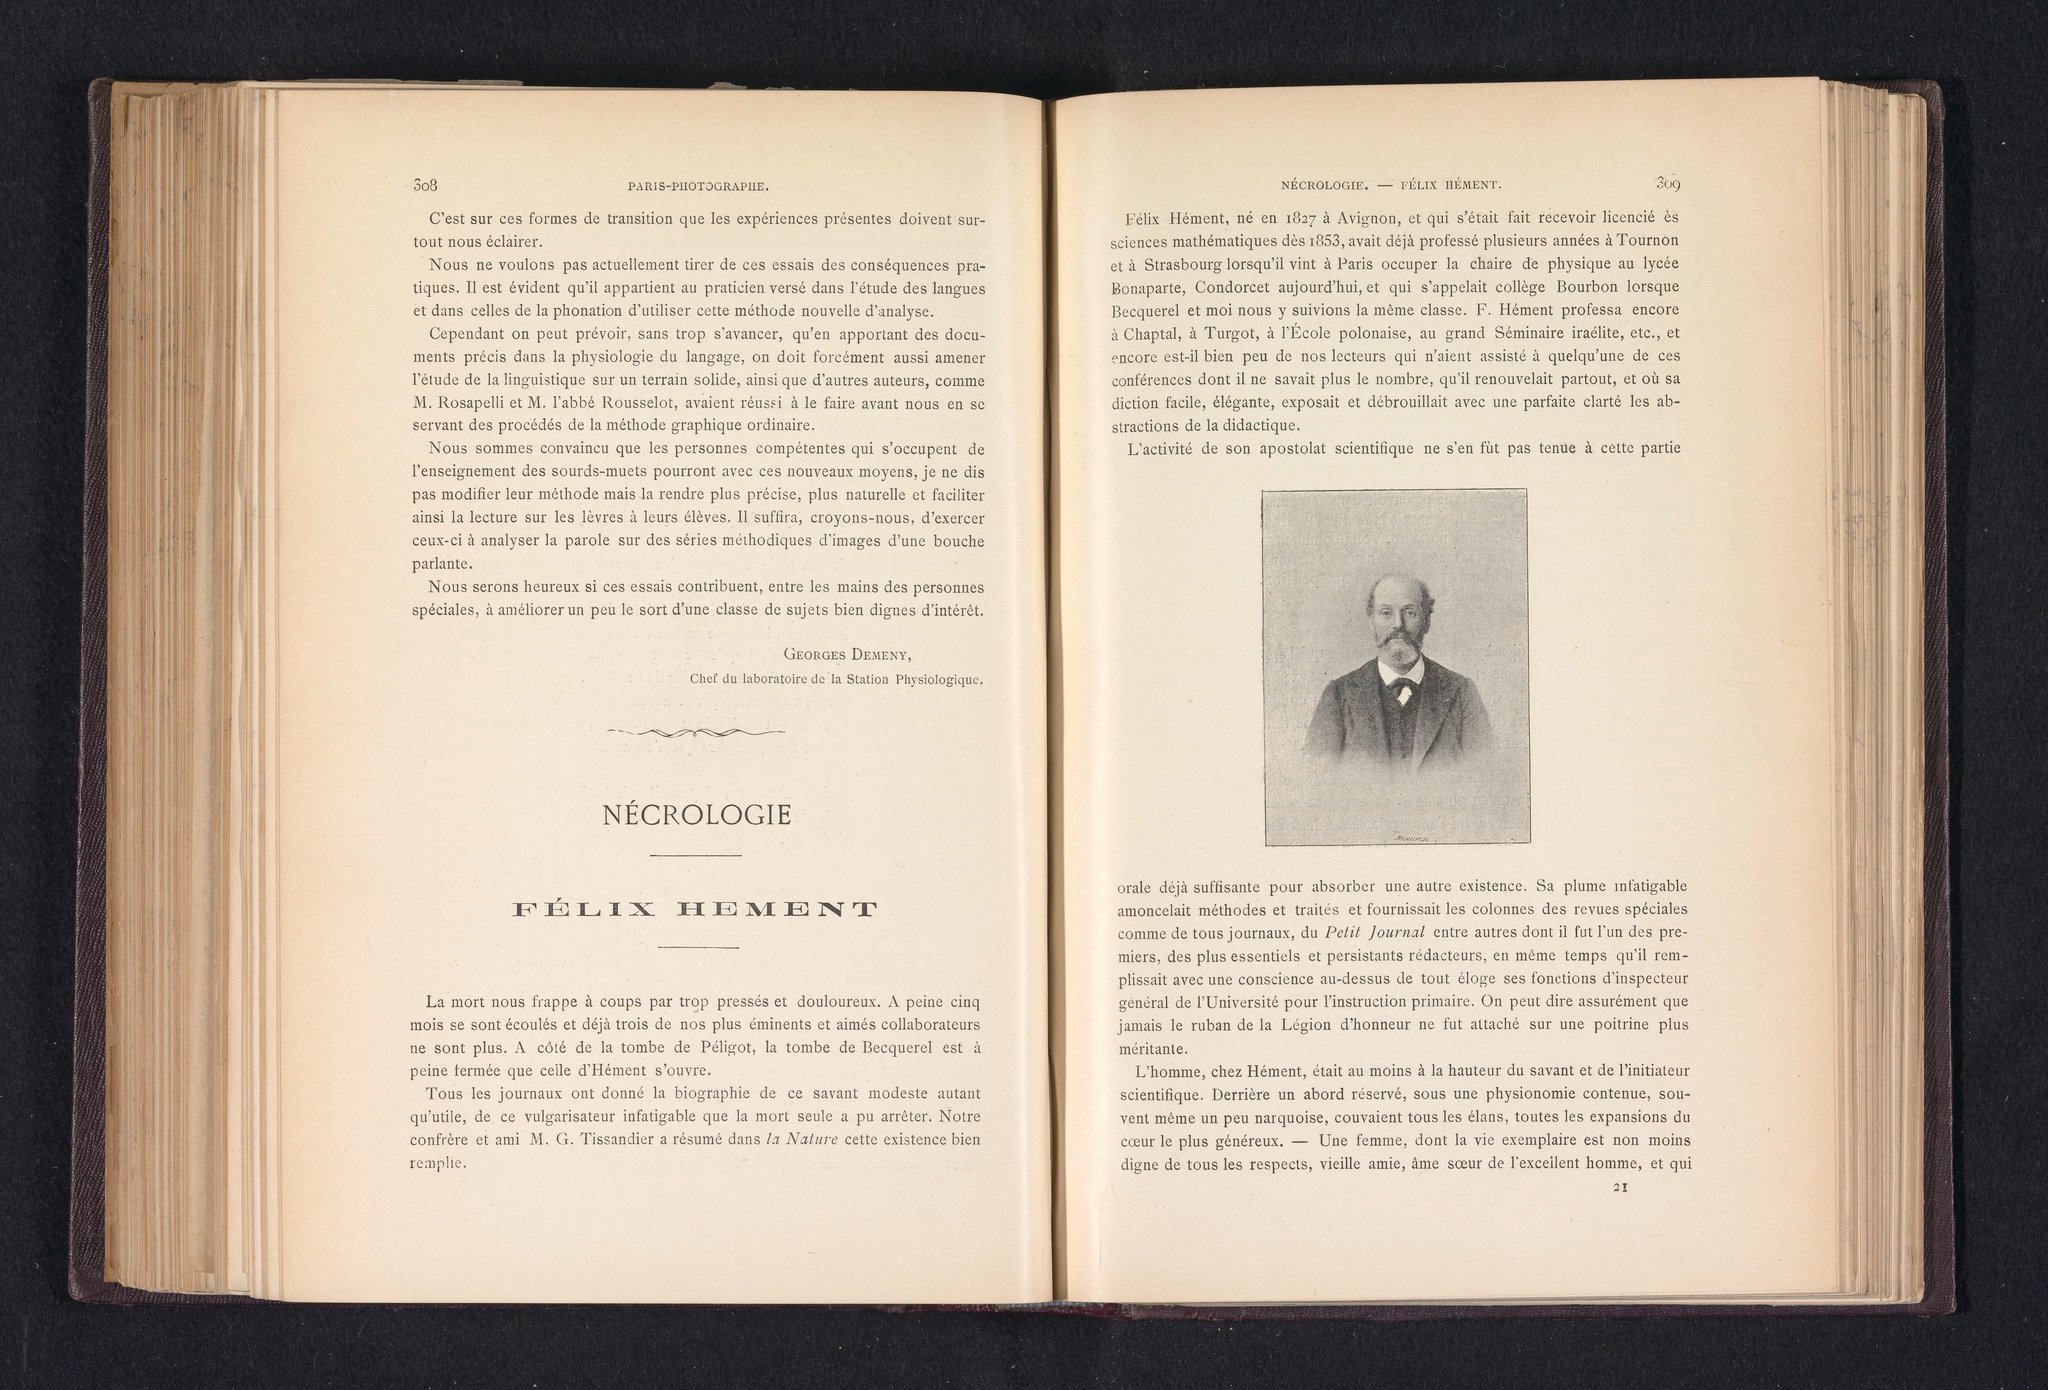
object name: photomechanical print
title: Portret van Félix Hement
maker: michelet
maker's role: print maker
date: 1881-1891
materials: paper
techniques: autotype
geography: france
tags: historical persons